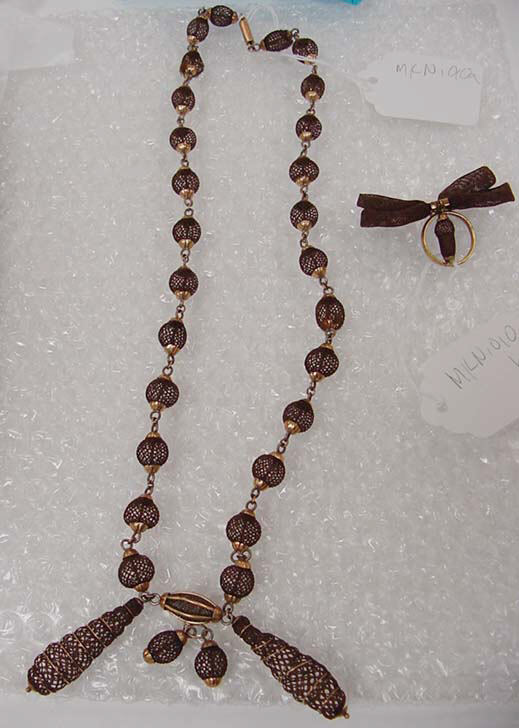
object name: jewelry set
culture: british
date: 1834-1866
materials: hair, metal